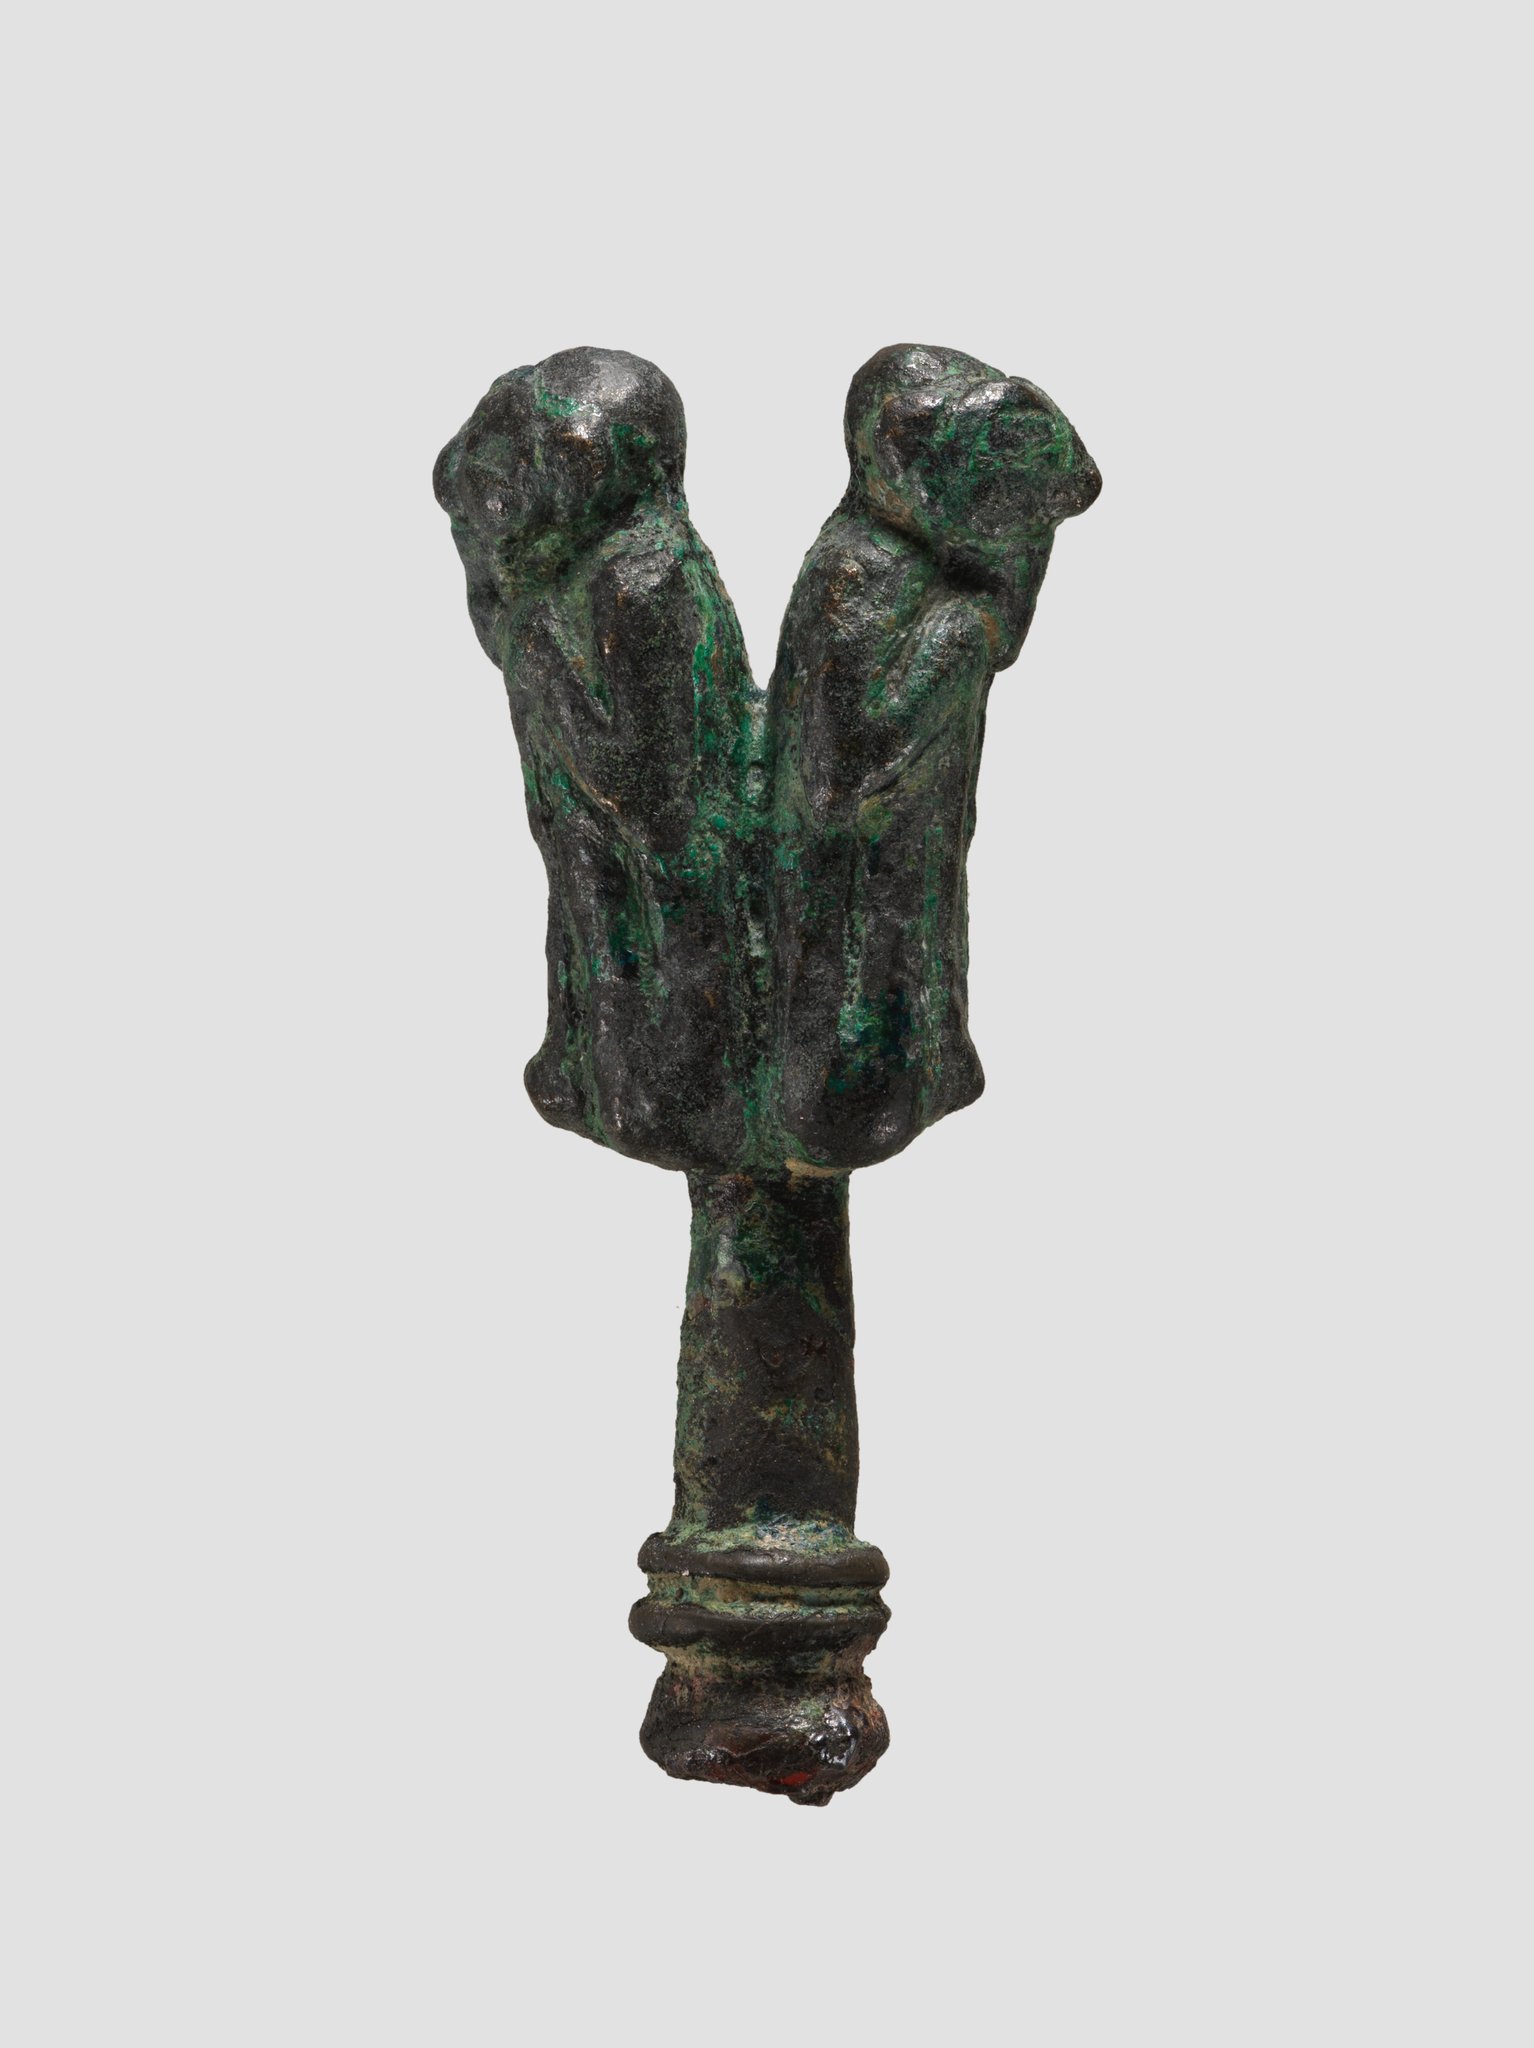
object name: pin head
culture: iranian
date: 1000-1 BCE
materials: bronze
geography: western iran